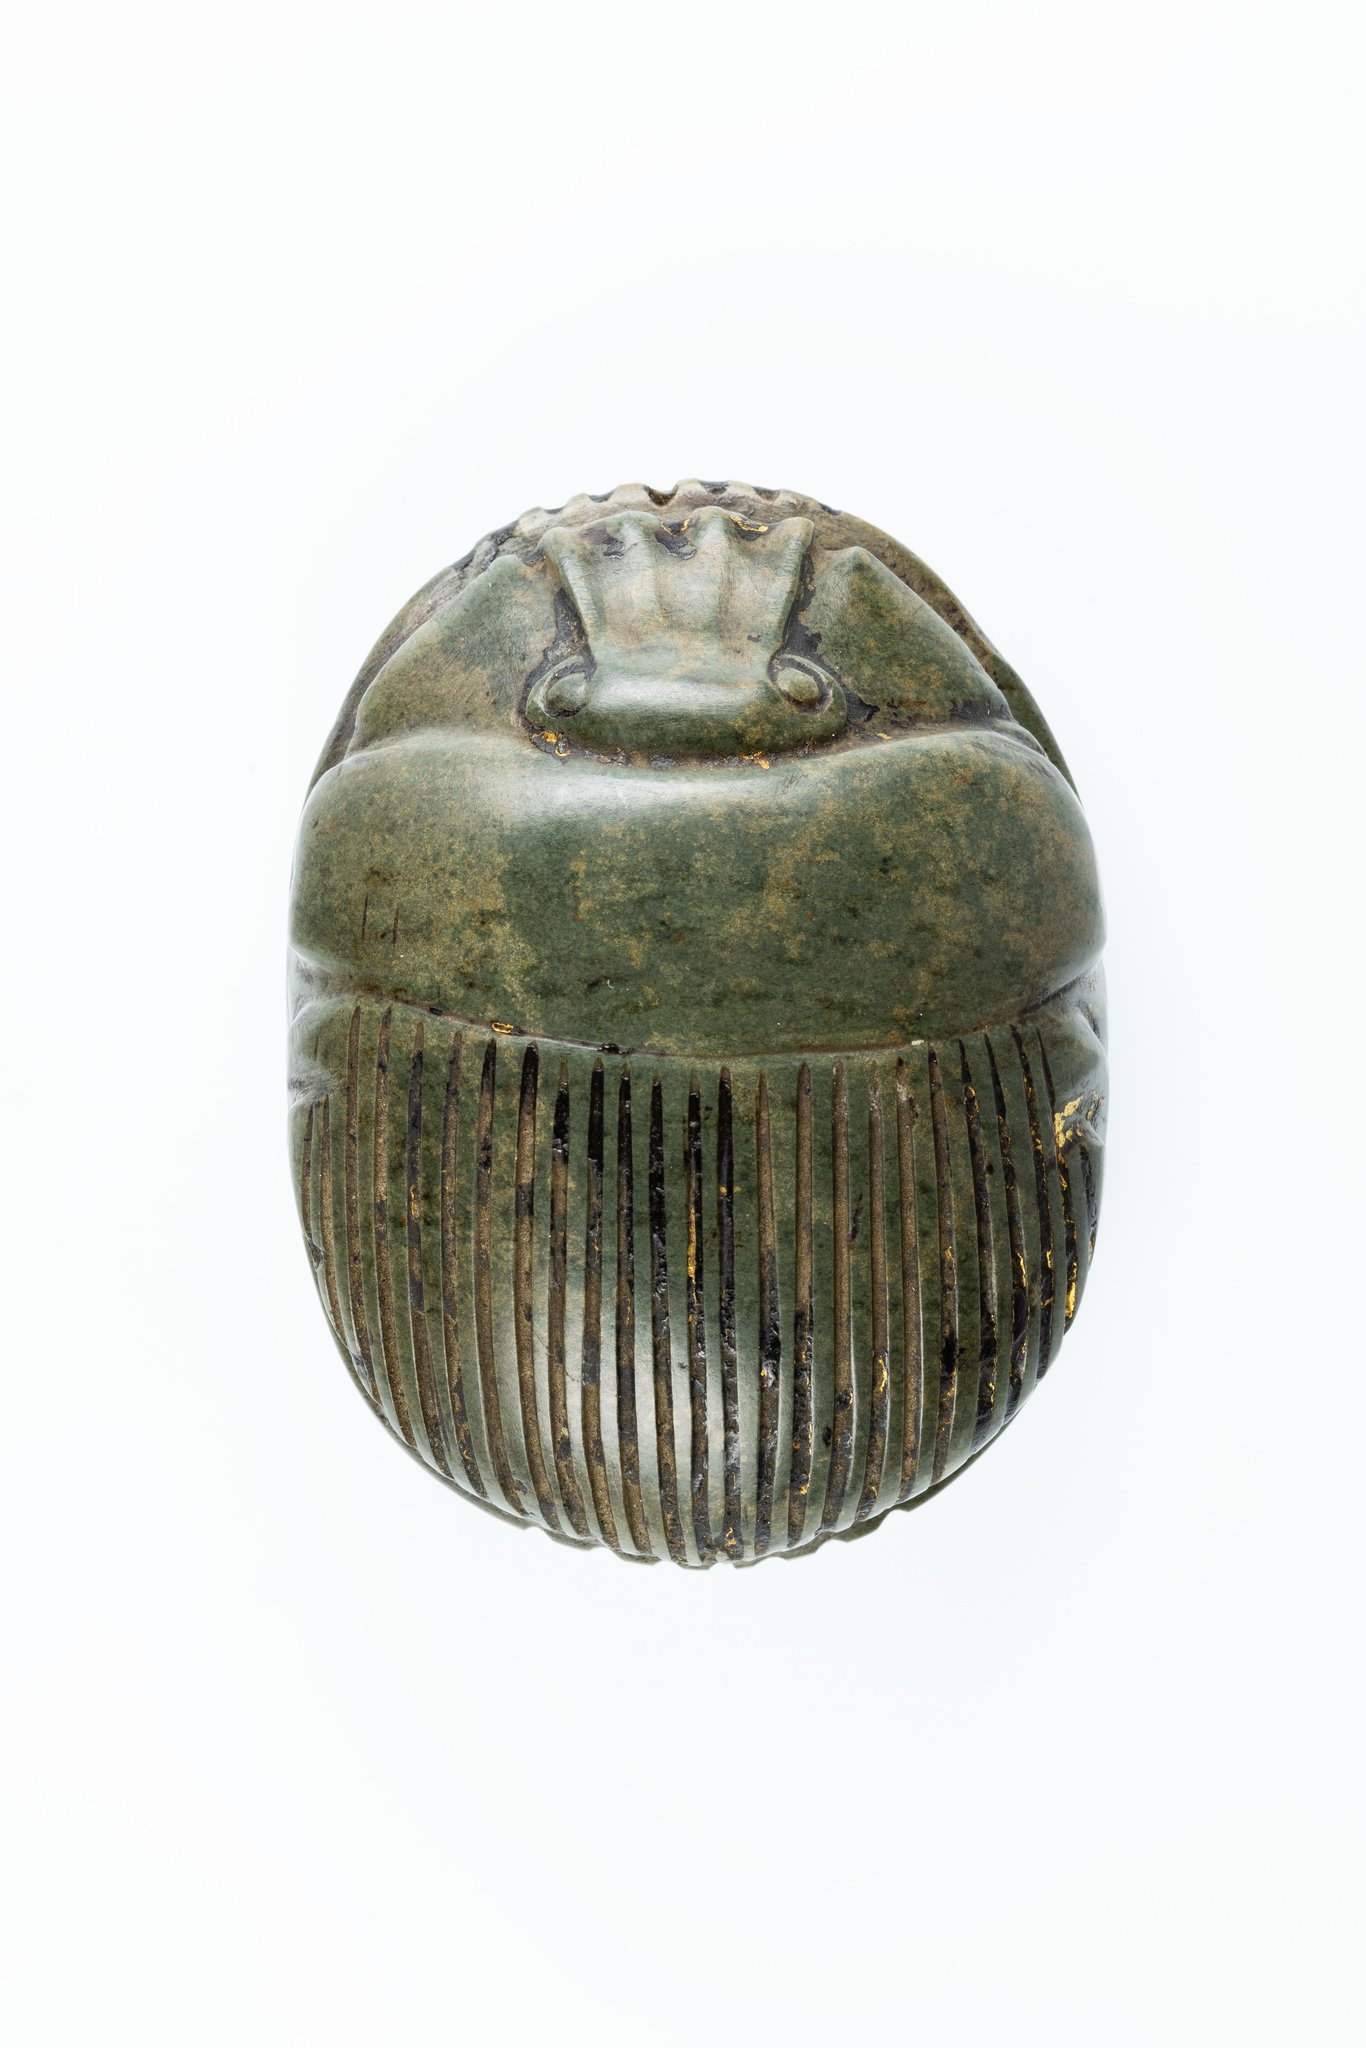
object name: heart scarab, uninscribed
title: Uninscribed Heart Scarab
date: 1070-664 BCE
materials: gold, stone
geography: egypt